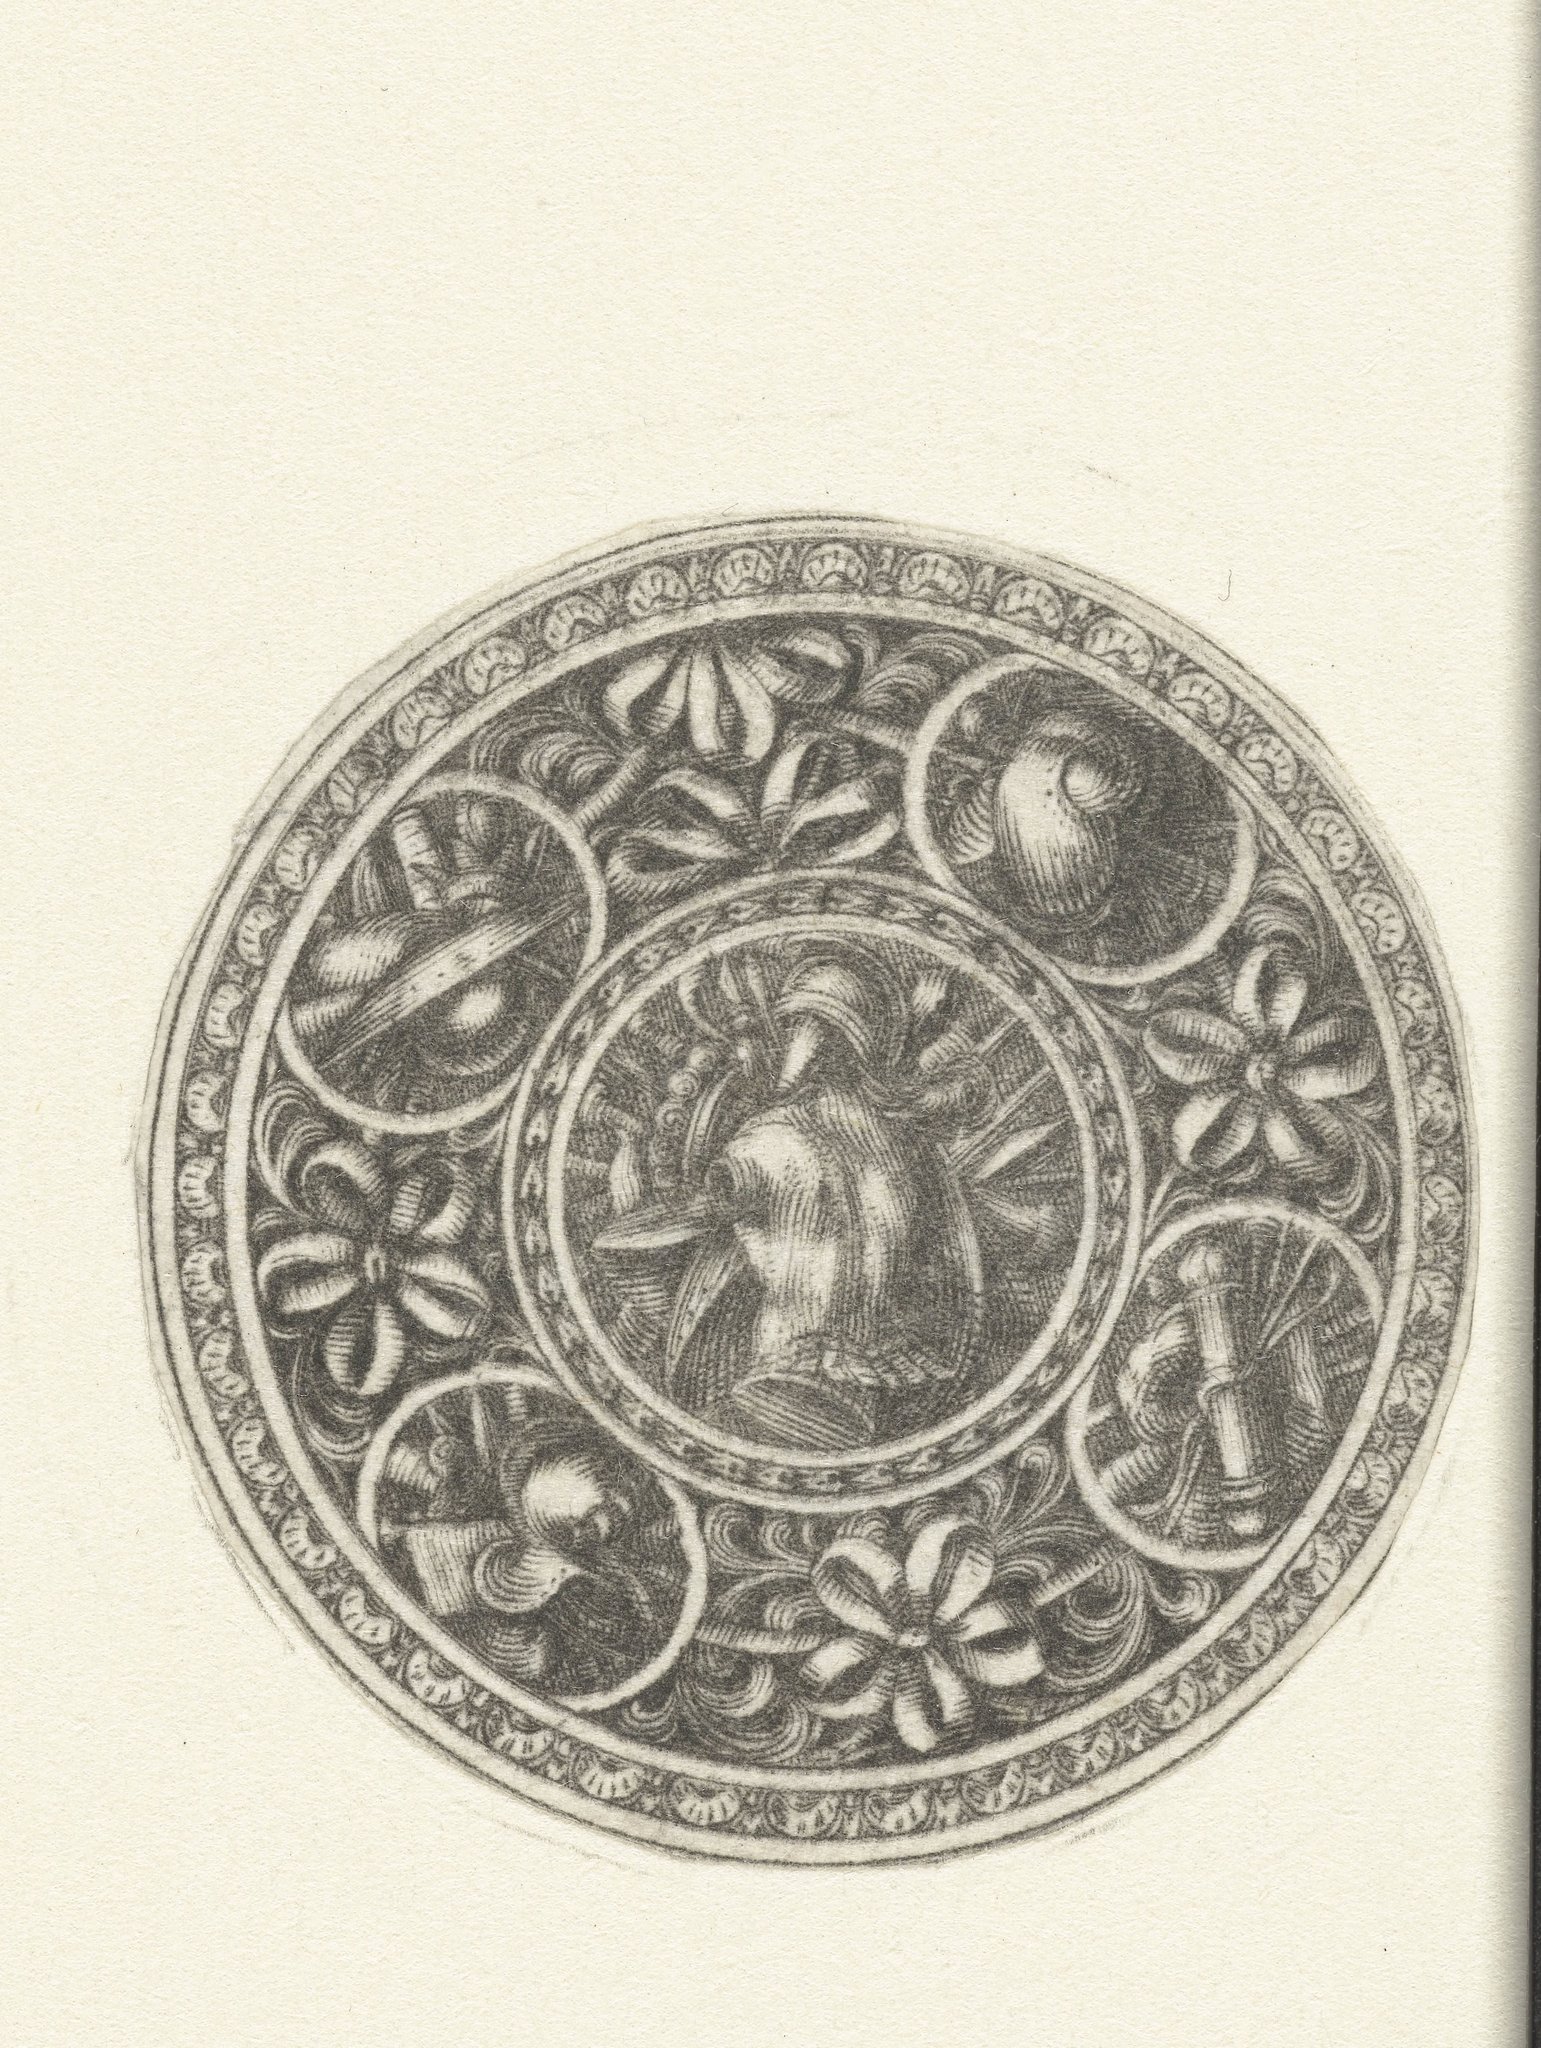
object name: print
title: Medaillon met wapentrofeeën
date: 1631-1686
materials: paper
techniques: engraving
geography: france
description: Medaillon van blad 6 uit de serie Liures De Fleurs propres pour O'rfeures Et Graueurs.